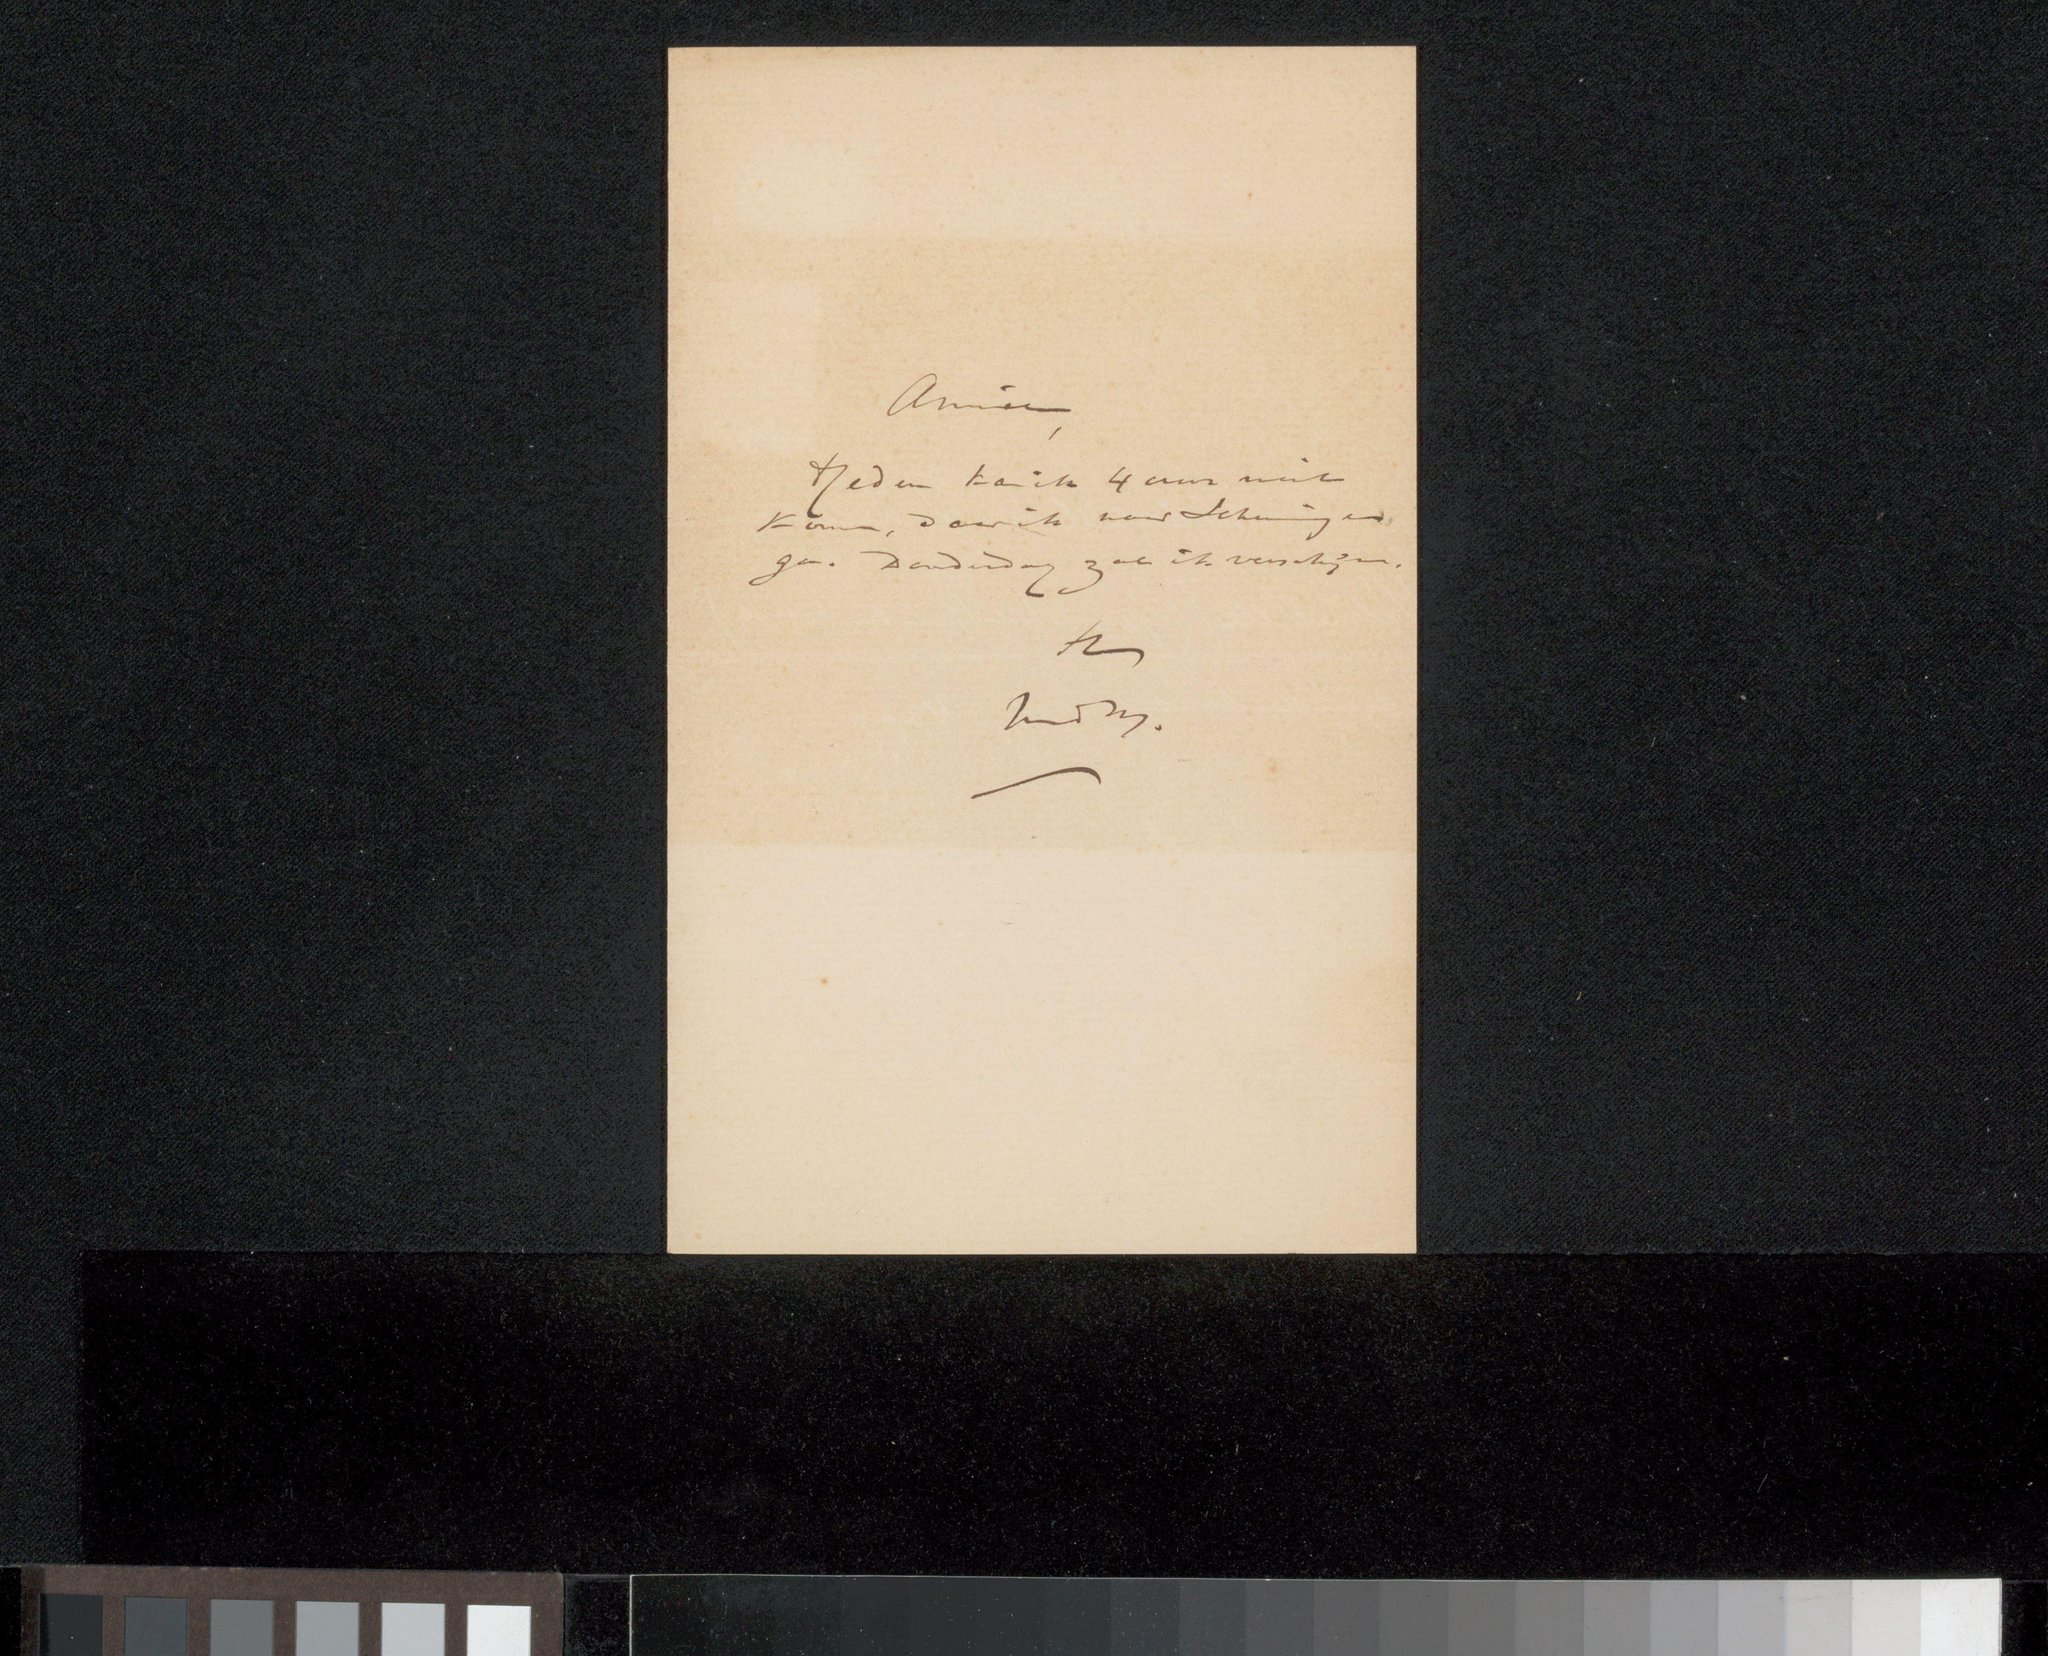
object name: letter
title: Brief aan Philip Zilcken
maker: marinus van der maarel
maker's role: draughtsman, painter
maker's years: 1857-1921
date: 1867-1921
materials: ink, paper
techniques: pen, writing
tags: the hague, painter, draughtsman, philip zilcken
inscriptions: collector's mark: ‘RPK’